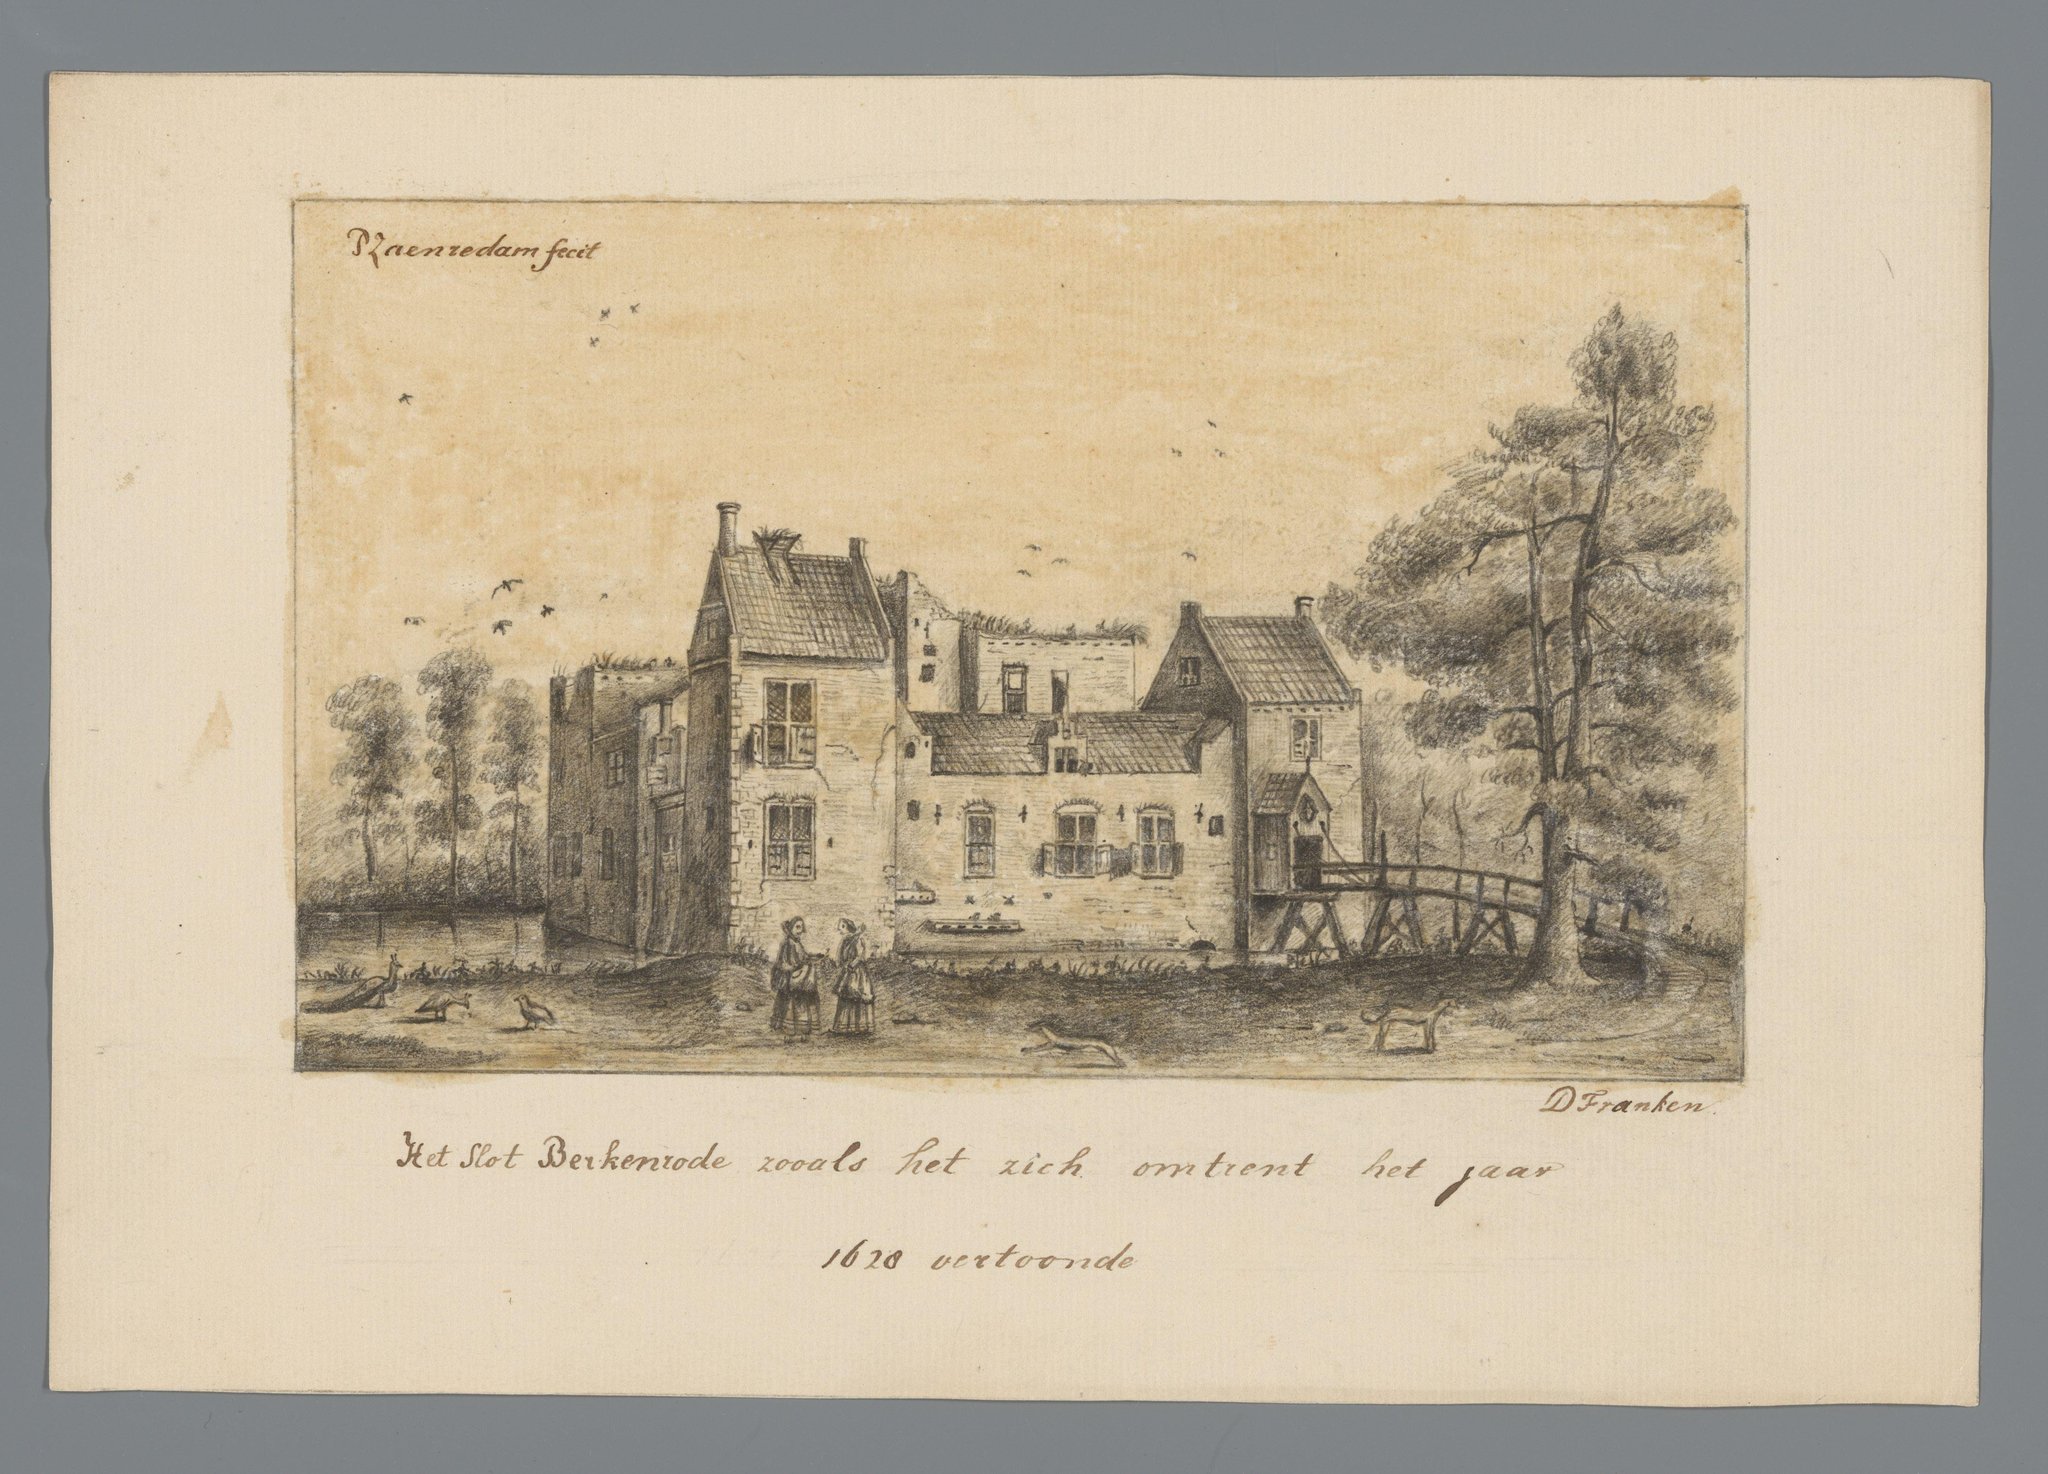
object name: drawing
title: Gezicht op het Slot Berkenrode, 1628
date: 1850-1870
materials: chalk, paper, varnish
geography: haarlem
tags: landscape with ruins (+ city(-scape) with figures, staffage), ruin of a dwelling, house, castle, etc.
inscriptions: inscription: ‘Het Slot Berkenrode zooals het zich omtrent het jaar 1628 vertoonde’, signature: ‘D. Franken’